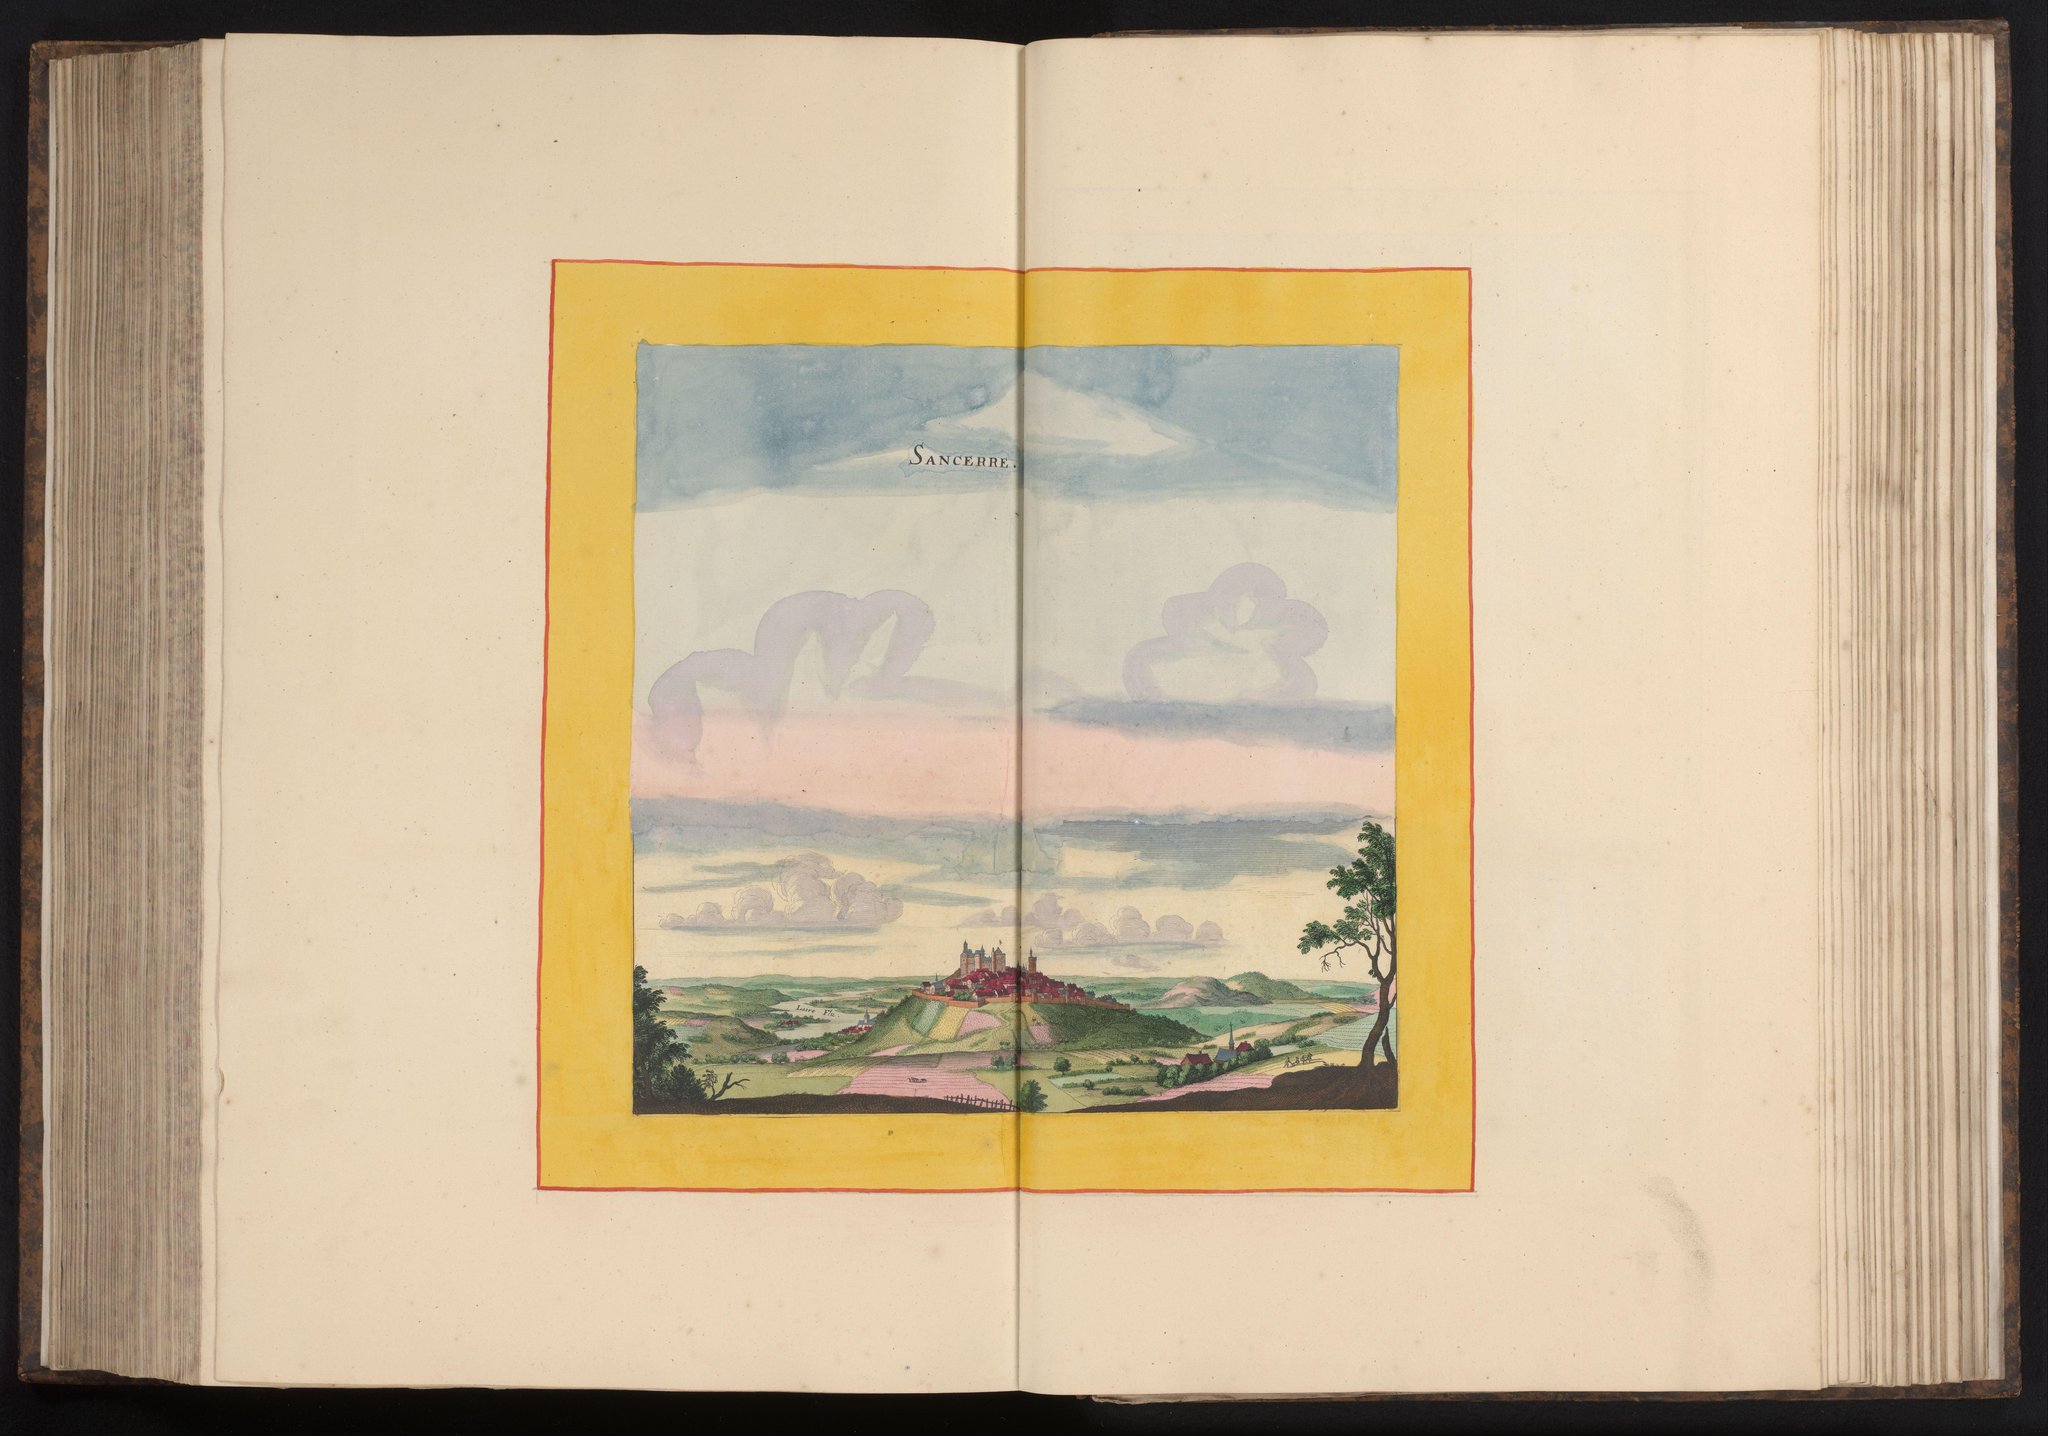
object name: album leaf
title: Sancerre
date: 1657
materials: paper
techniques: engraving, etching, hand coloring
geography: frankfurt am main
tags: city-view in general; 'veduta'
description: Prent uit: Zeiller, Martin. Topographia Galliae. 13 dln. Frankfurt: Caspar Merian, 1657, dl. 6, na p. 20. De titel is uit de originele prent gesneden. Boven de gravure is een deel lucht en wolken (bij)geschilderd, waarin de titel gelijmd is. Origineel gedrukt op één blad met een soortgelijk gezicht op Limoges (RP-P-1956-286).